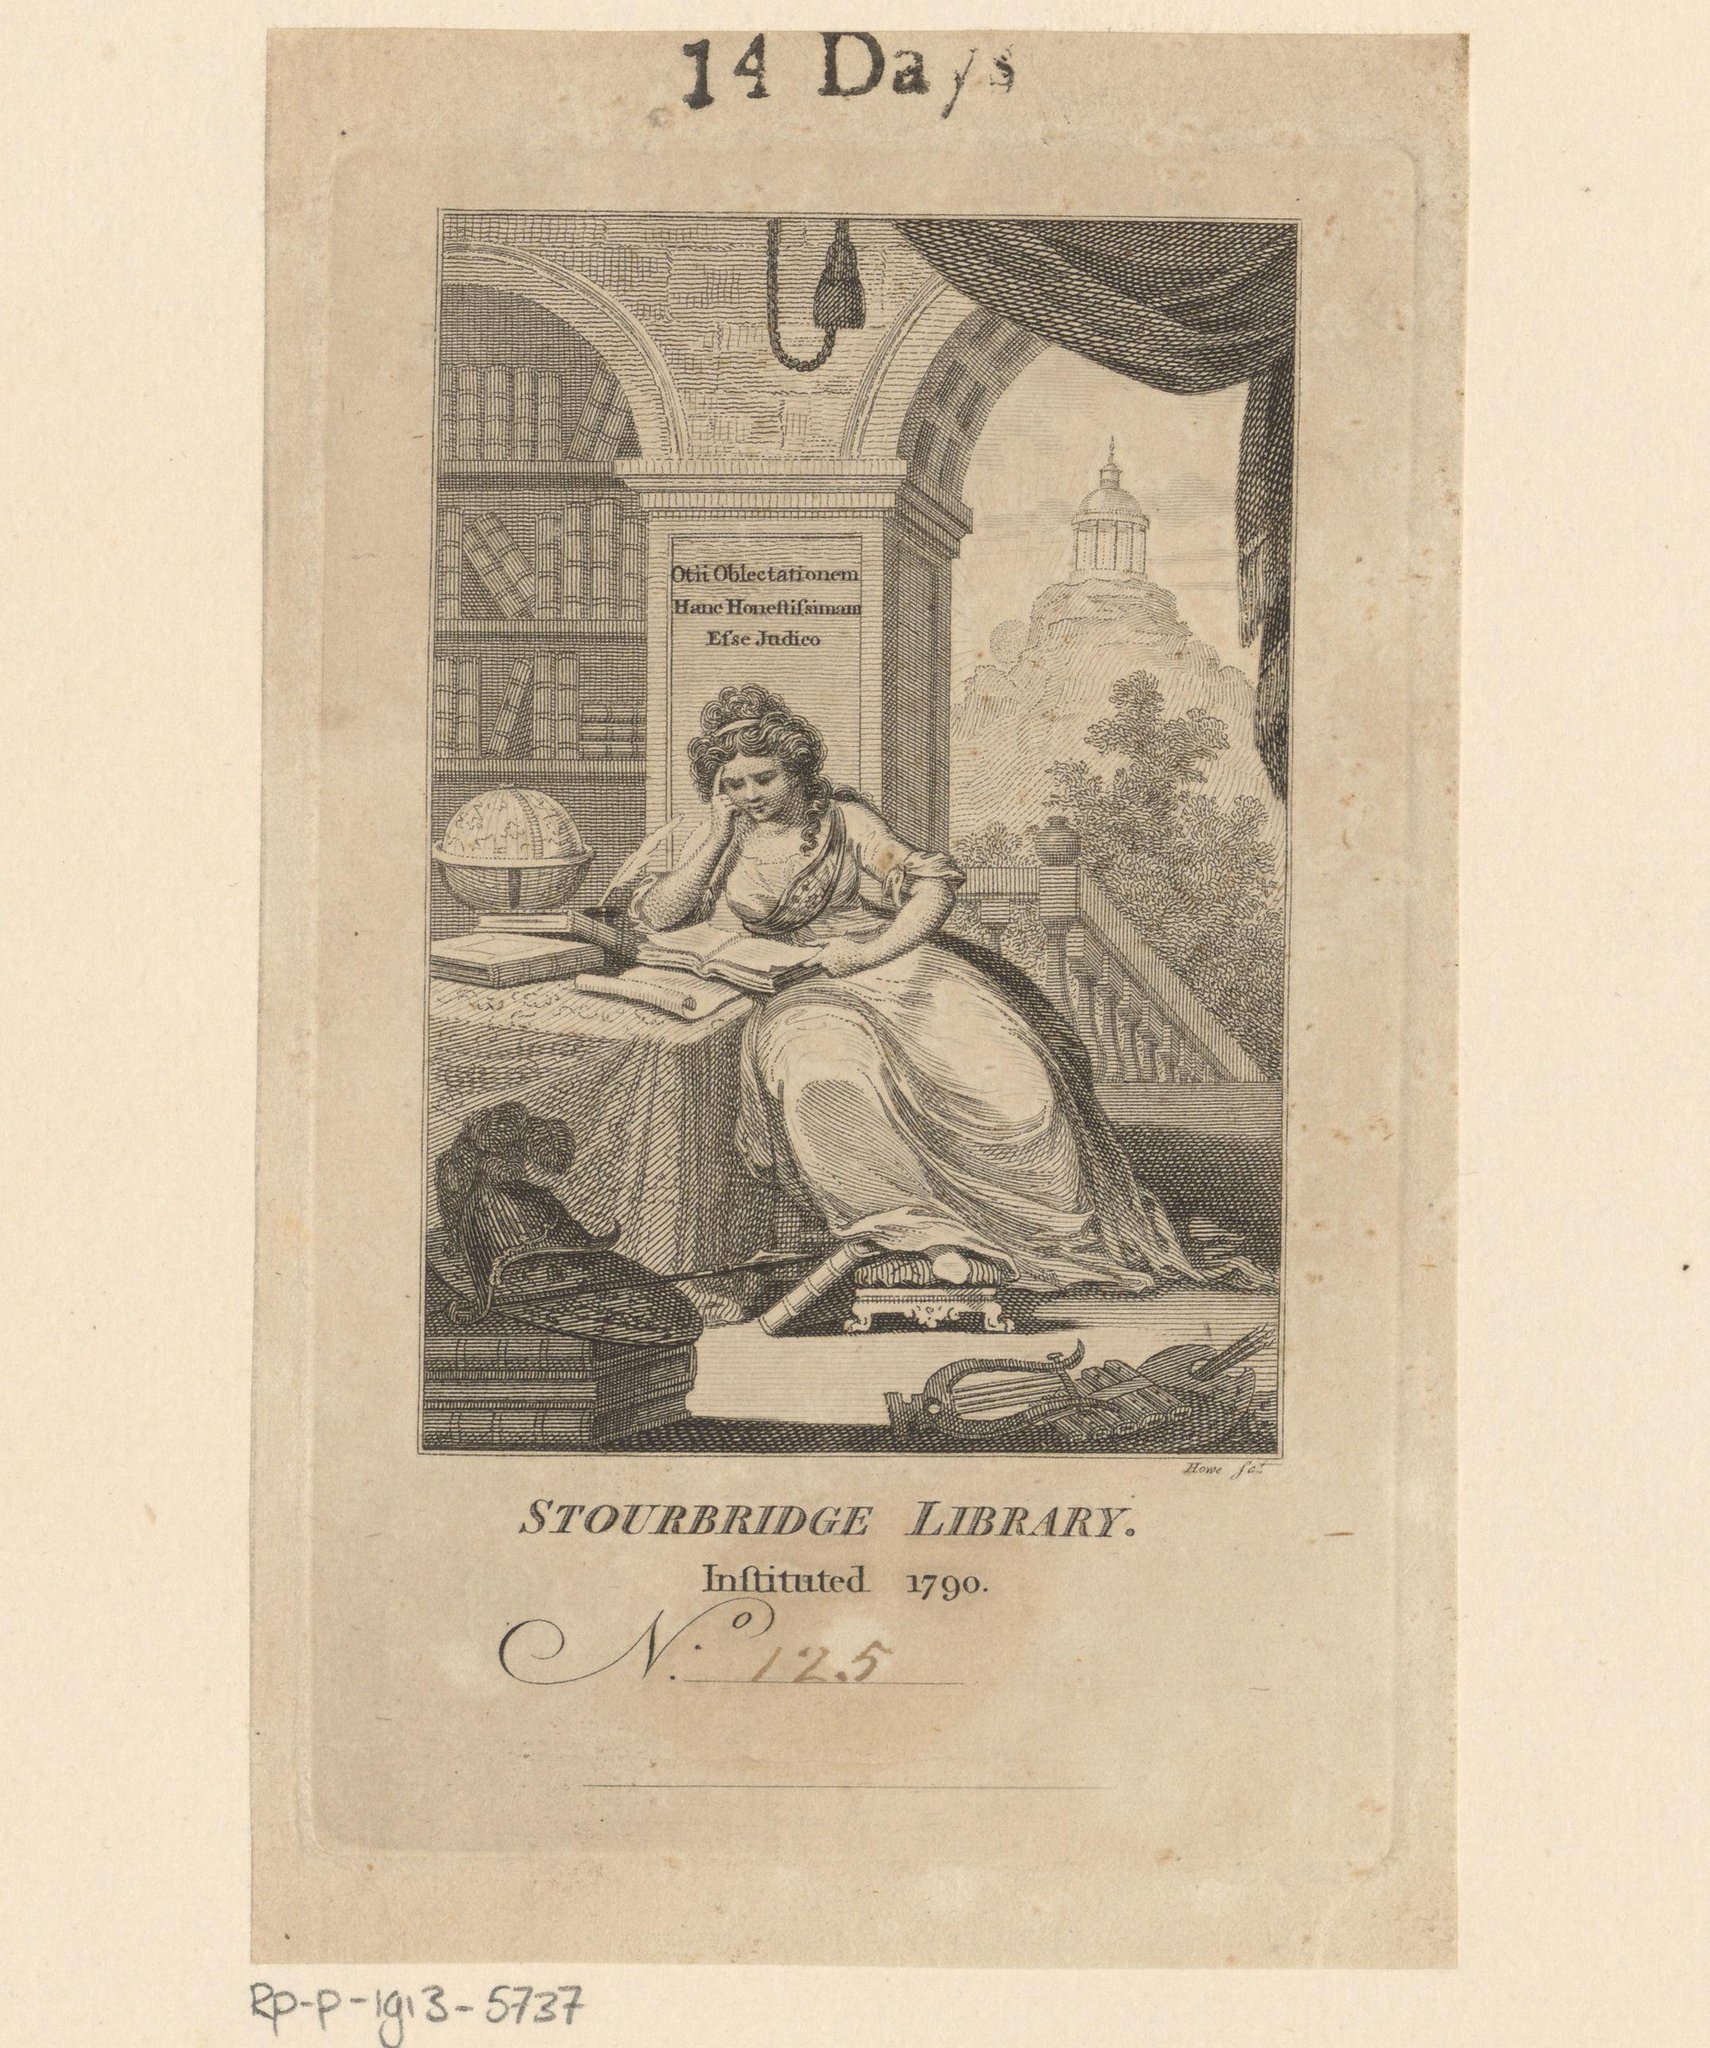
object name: bookplate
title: Otii Oblectationem Hanc Honestissimam Esse Judico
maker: howe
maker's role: print maker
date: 1790-1849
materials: paper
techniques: engraving, etching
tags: study; 'studiolo'; library, specific aspects, allegorical aspects of minerva; minerva as patroness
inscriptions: collector's mark: Lugt 2233, number: ‘125’, collector's mark: Lugt 2760, inscription: ‘14 Days’